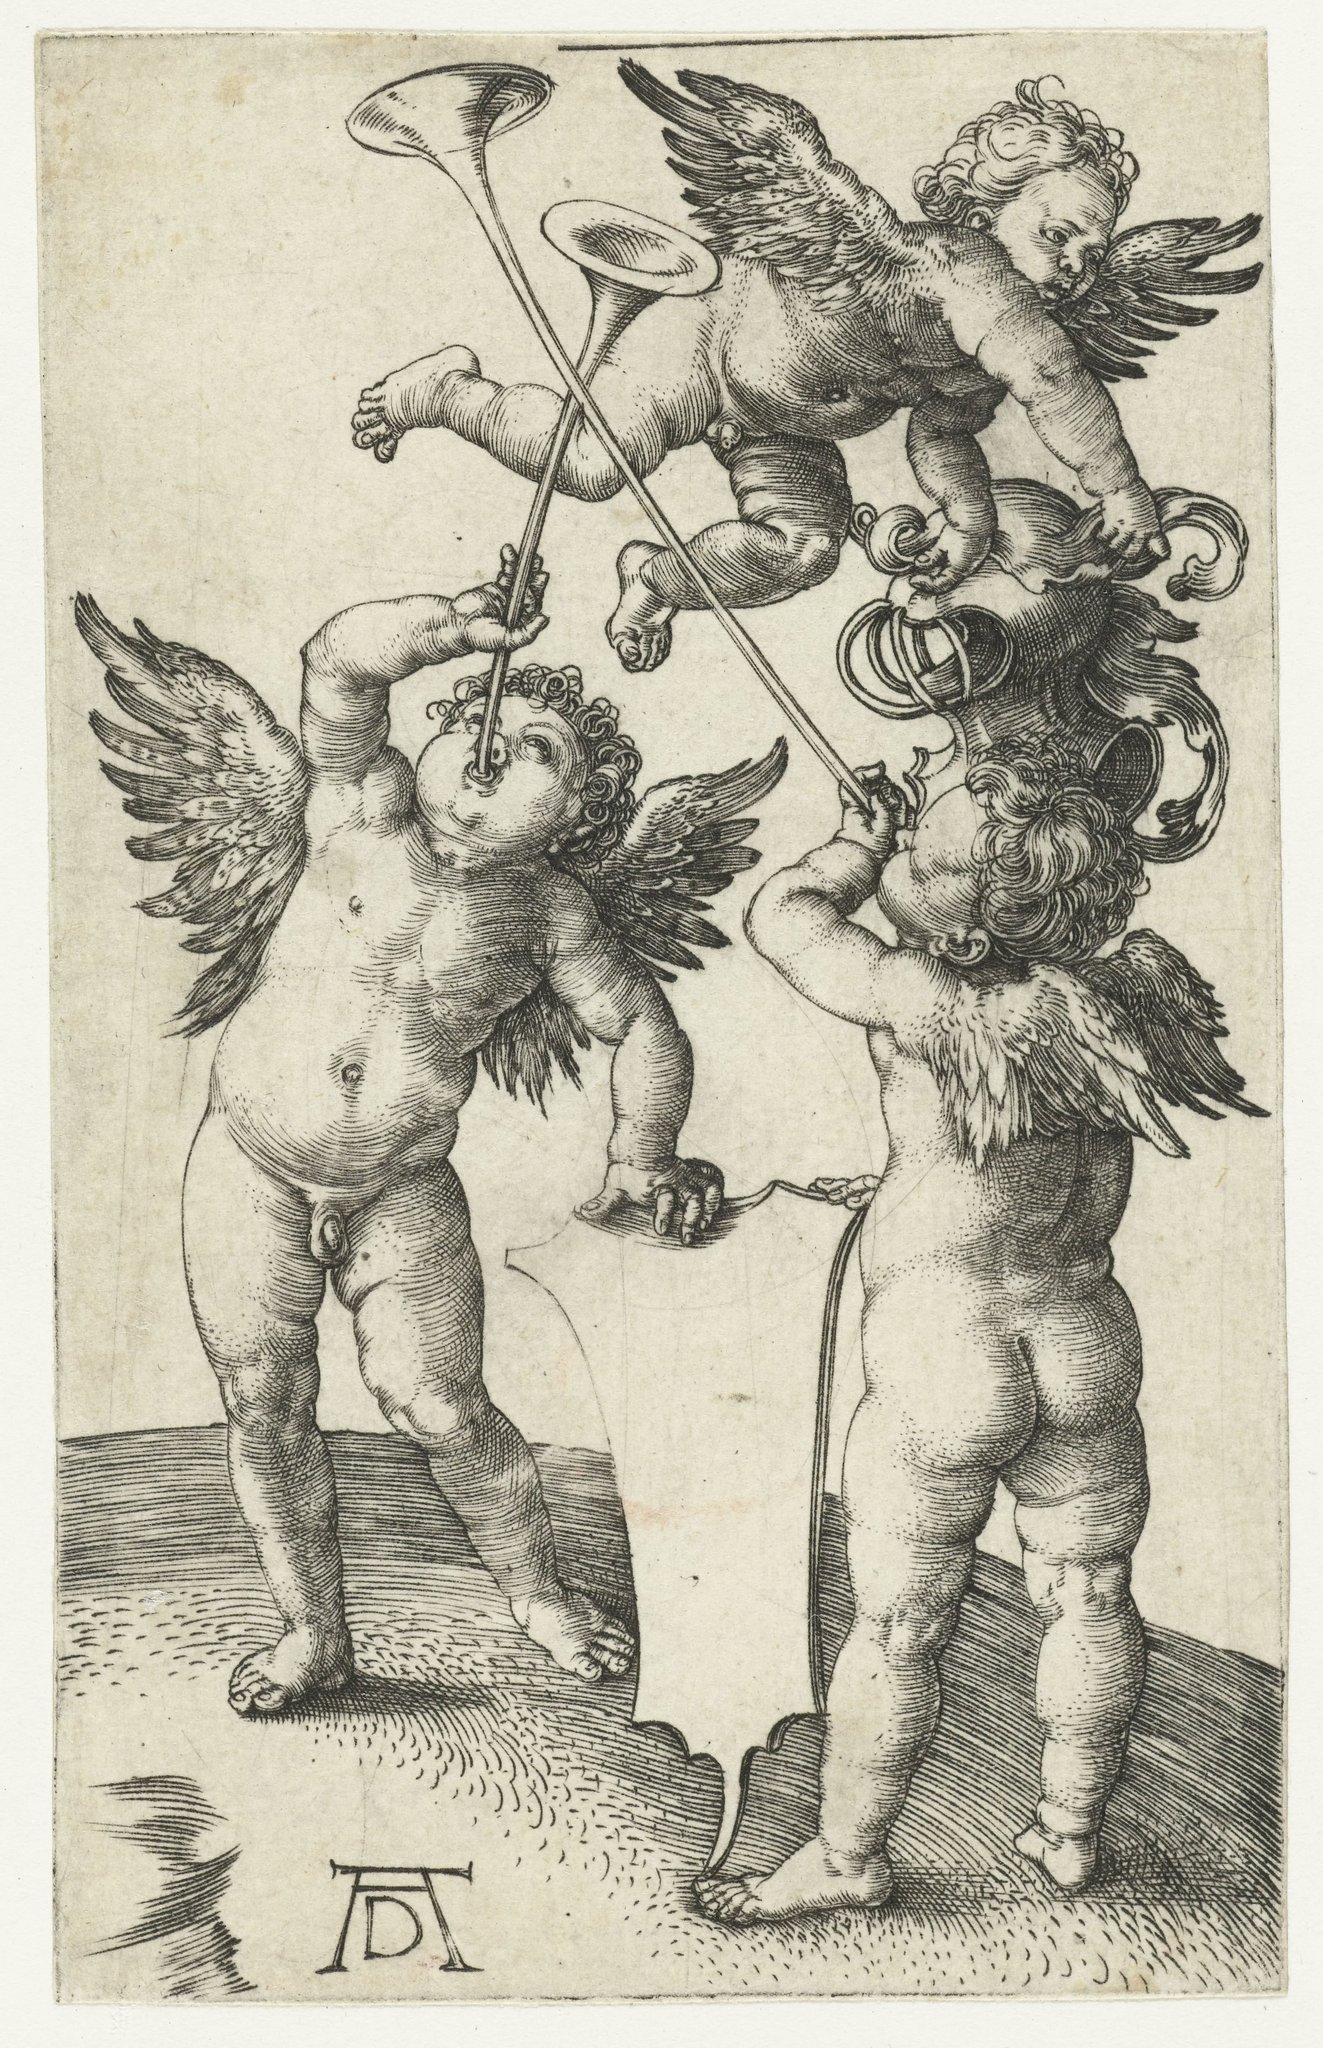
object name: print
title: Drie putti met trompetten, schild en helm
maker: albrecht dürer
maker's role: draughtsman, painter, print maker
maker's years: 1471-1528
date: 1498-1502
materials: paper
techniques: engraving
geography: nuremberg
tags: cupids together with attributes of the arts, sciences, etc.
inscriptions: collector's mark: Lugt 2228a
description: Twee putti houden met de ene hand elk een trompet aan hun mond en met de andere hand samen een schild vast. Een derde putto vliegt boven hen met een helm in de handen.